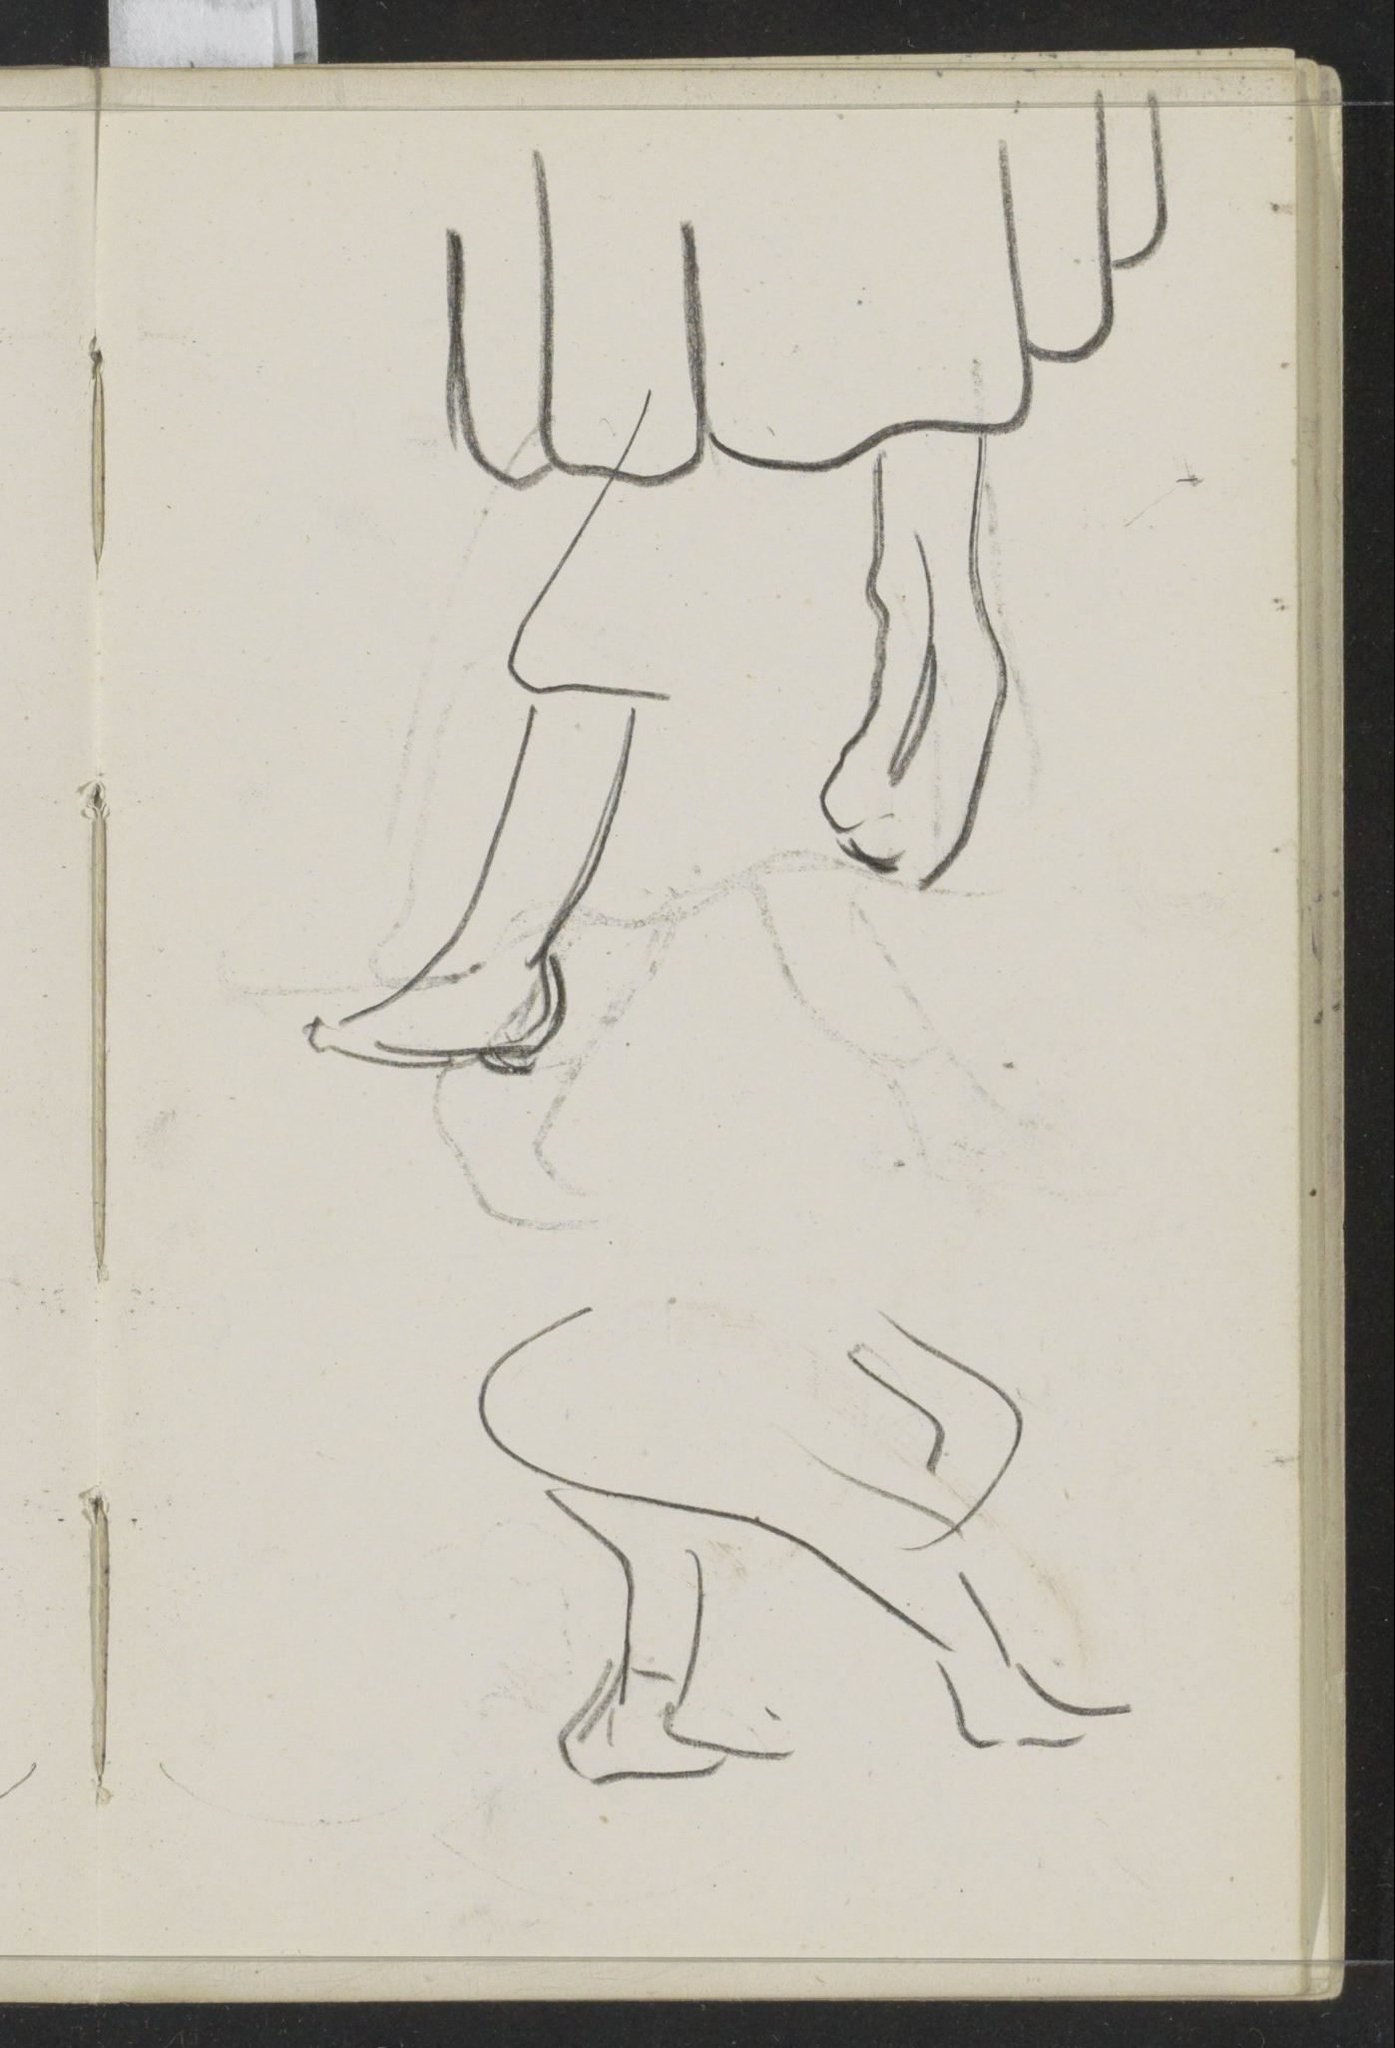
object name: sketchbook leaf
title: Onderlichaam, voeten en een rok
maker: carel adolph lion cachet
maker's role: draughtsman, print maker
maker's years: 1864-1945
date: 1874-1945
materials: chalk, paper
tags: skirt, legs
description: Blad 22 recto uit een schetsboek met 41 bladen.